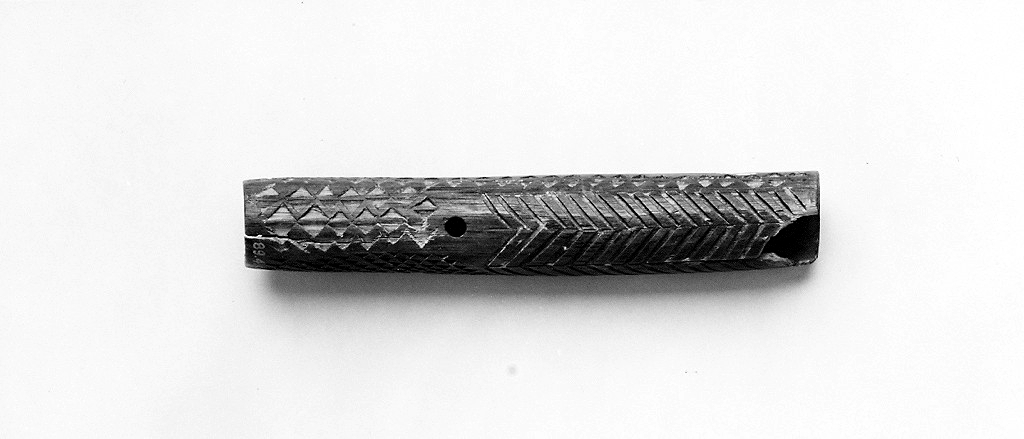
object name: flute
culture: fan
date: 1867-1900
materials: wood